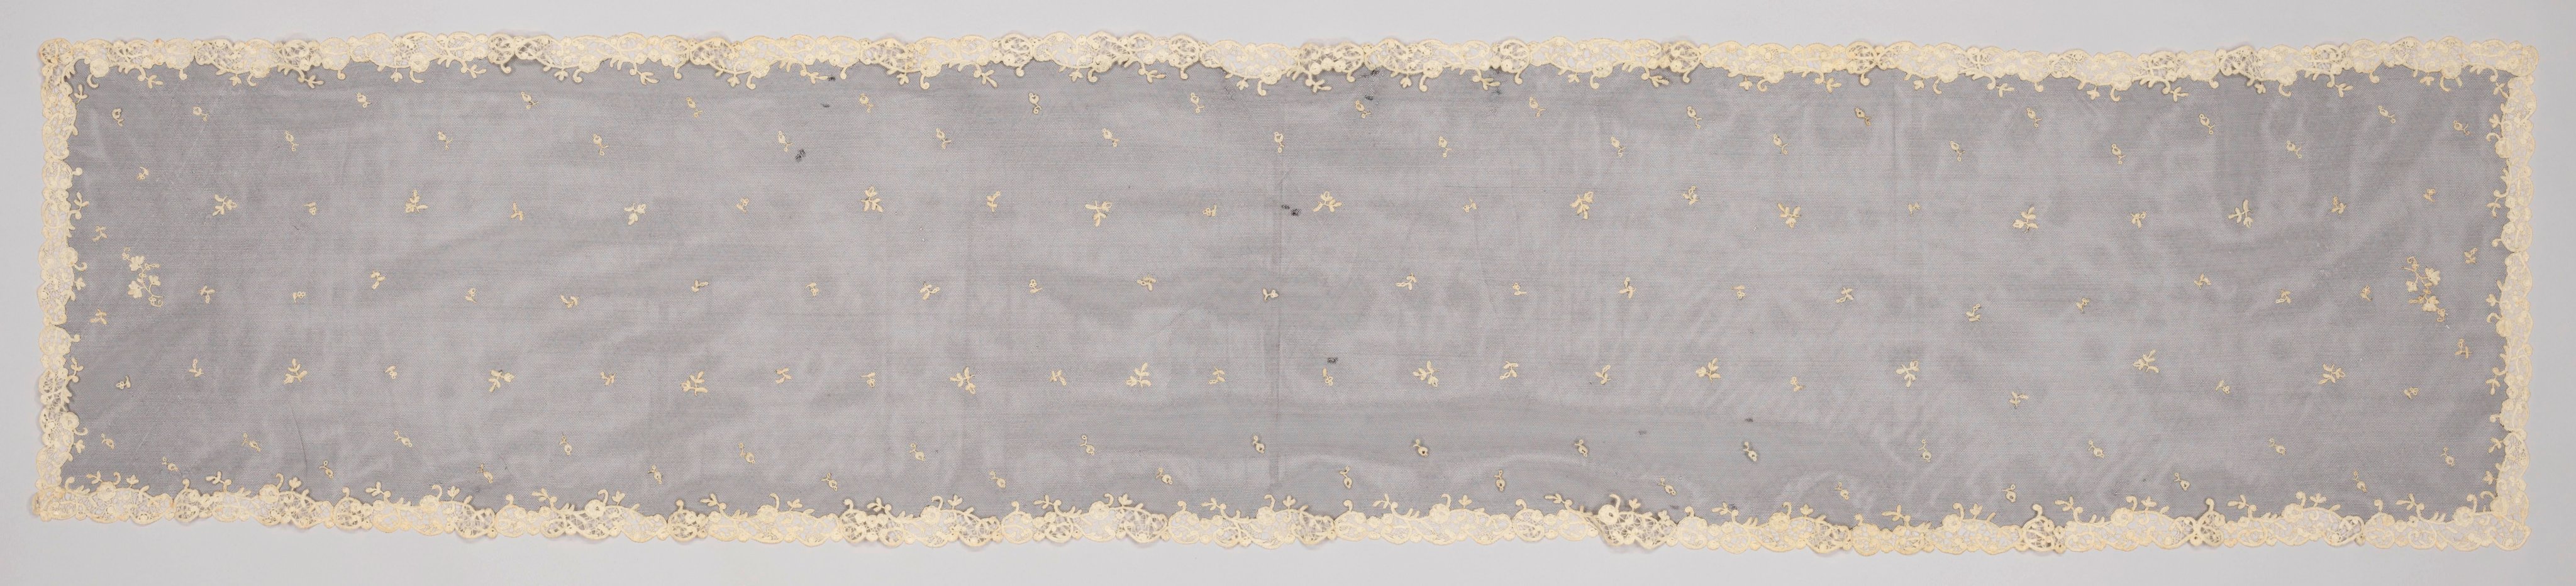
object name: scarf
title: Sjaal van applicatiekant met witte kloskant op zwarte machinale tule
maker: Anonymous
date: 1880-1889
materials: linen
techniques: lace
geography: brussels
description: Sjaal van applicatiekant, witte kloskant - fijn Brugs bloemwerk - op zwarte machinale tule. Rechthoekig model. Het bloemwerk bestaat in het middenveld uit wijd gestrooide bloemtakjes en voor de vier geschulpte randen uit een ornament, dat tegen een spijlenfond staat. Het ornament van de randkant vertoont neo-rokoko rocailles met kleine roosjes als knooppunten der schulpen en rozen, die met rankjes en blaadjes overlopen op het zwarte fond.